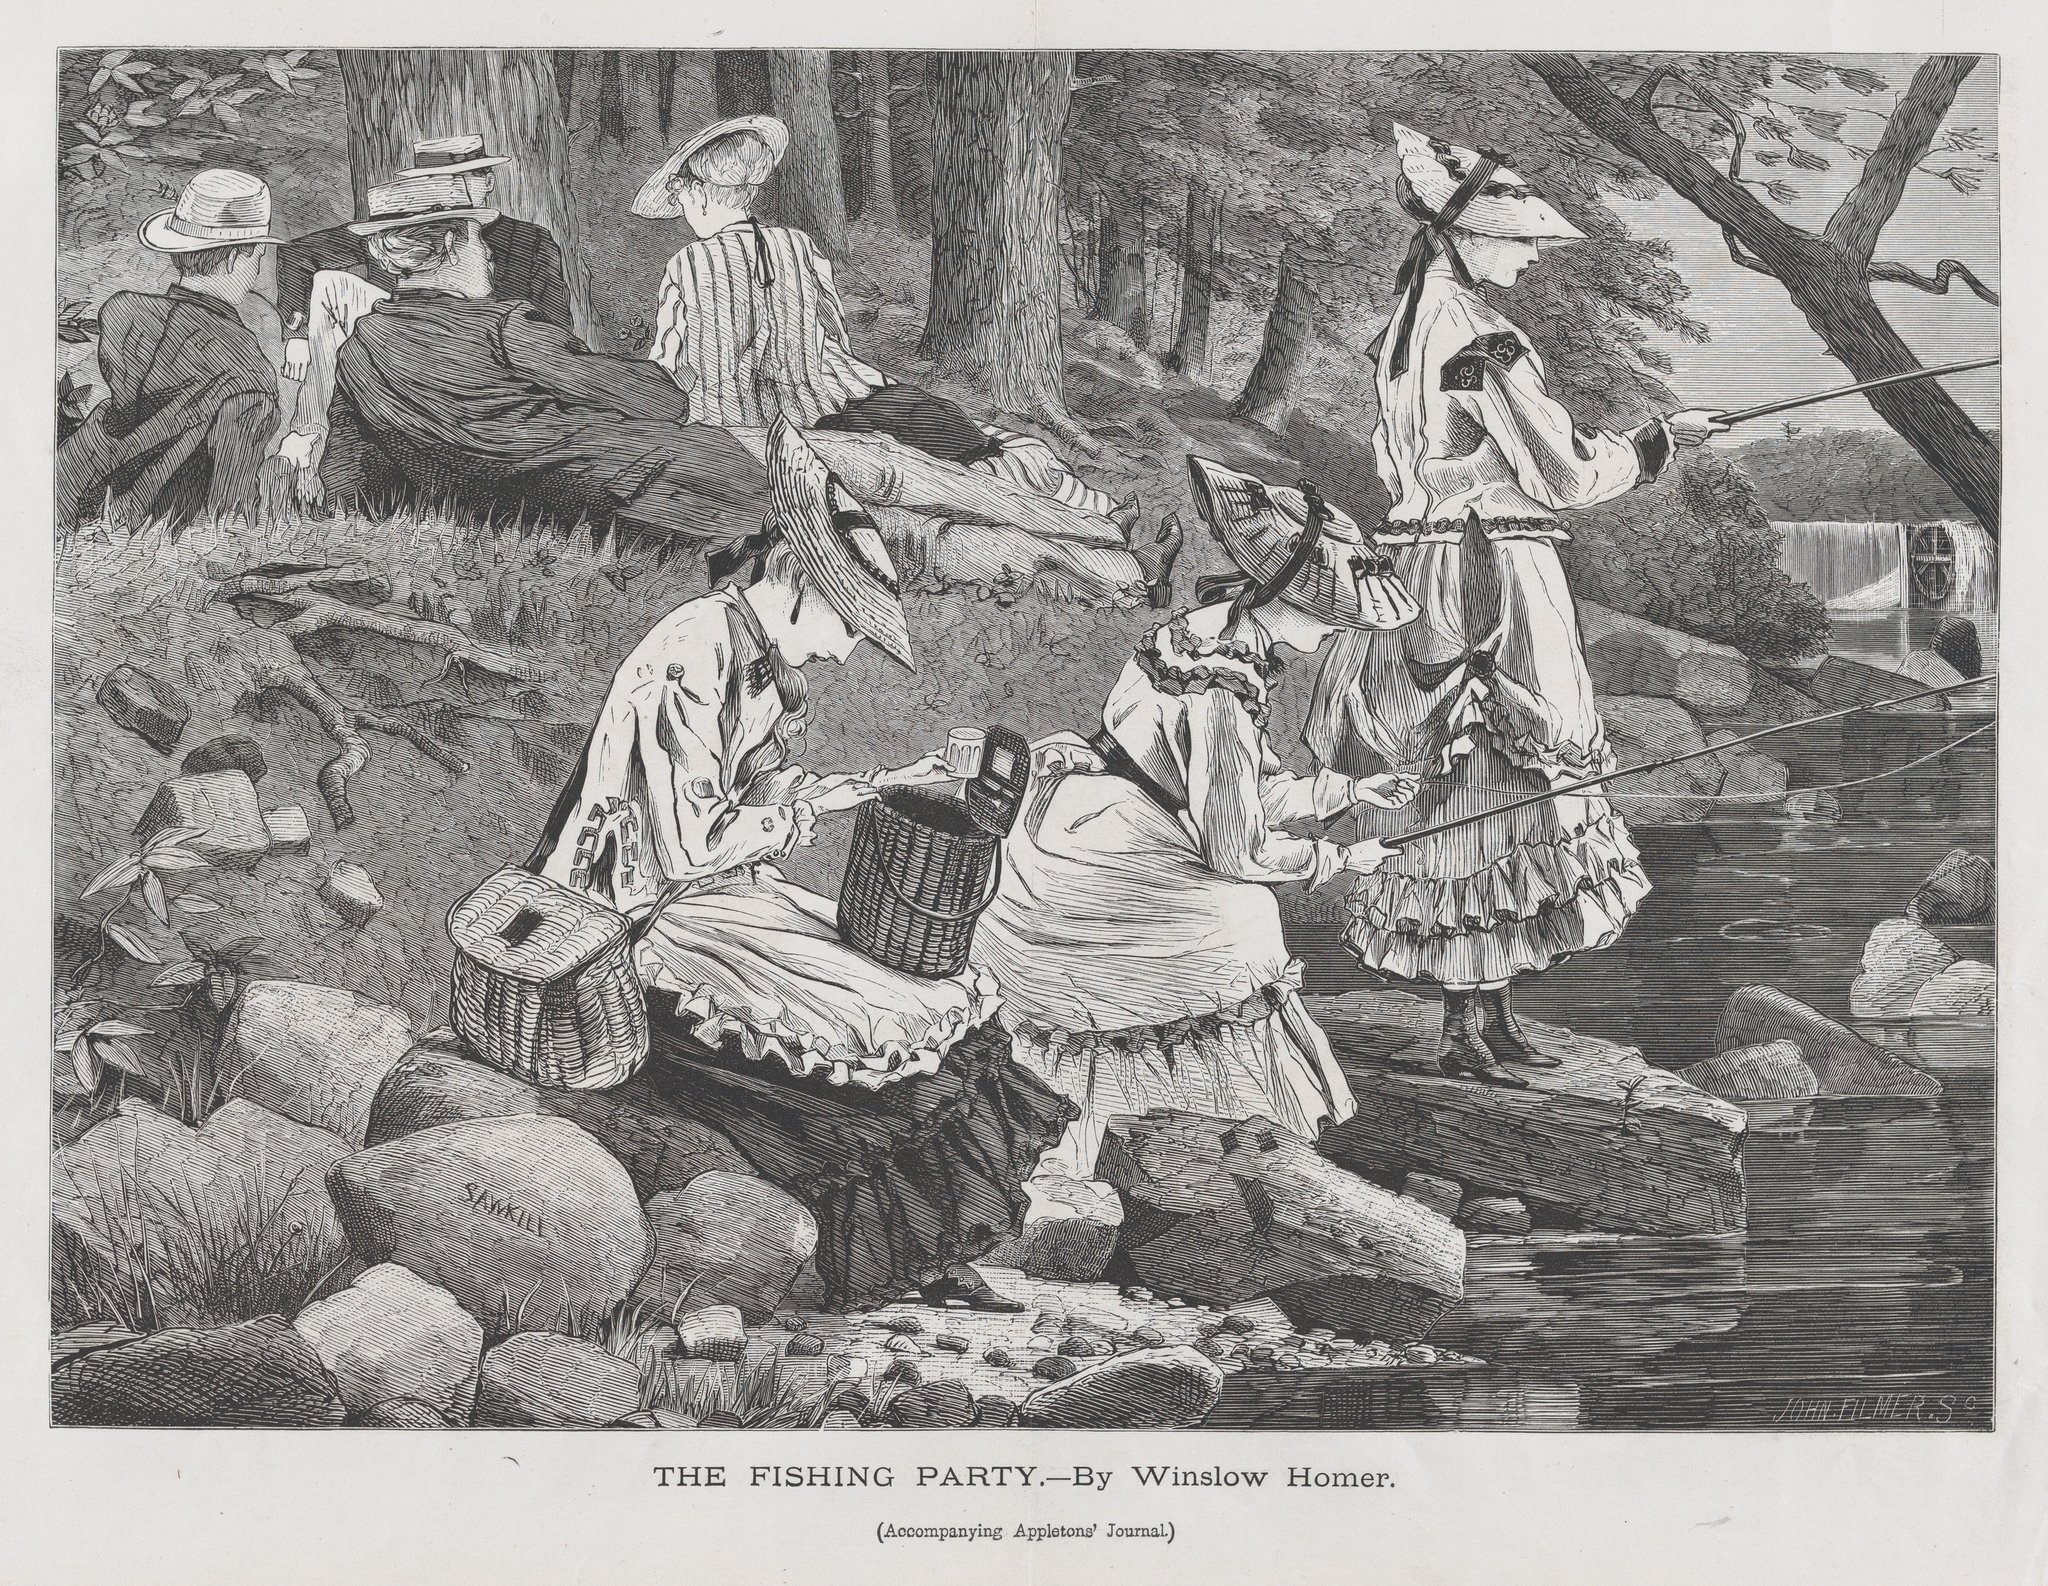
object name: print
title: The Fishing Party (from "Appleton's Journal," Vol. II)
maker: winslow homer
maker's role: artist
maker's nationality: american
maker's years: 1836-1910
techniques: engraving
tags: men,women,fishing